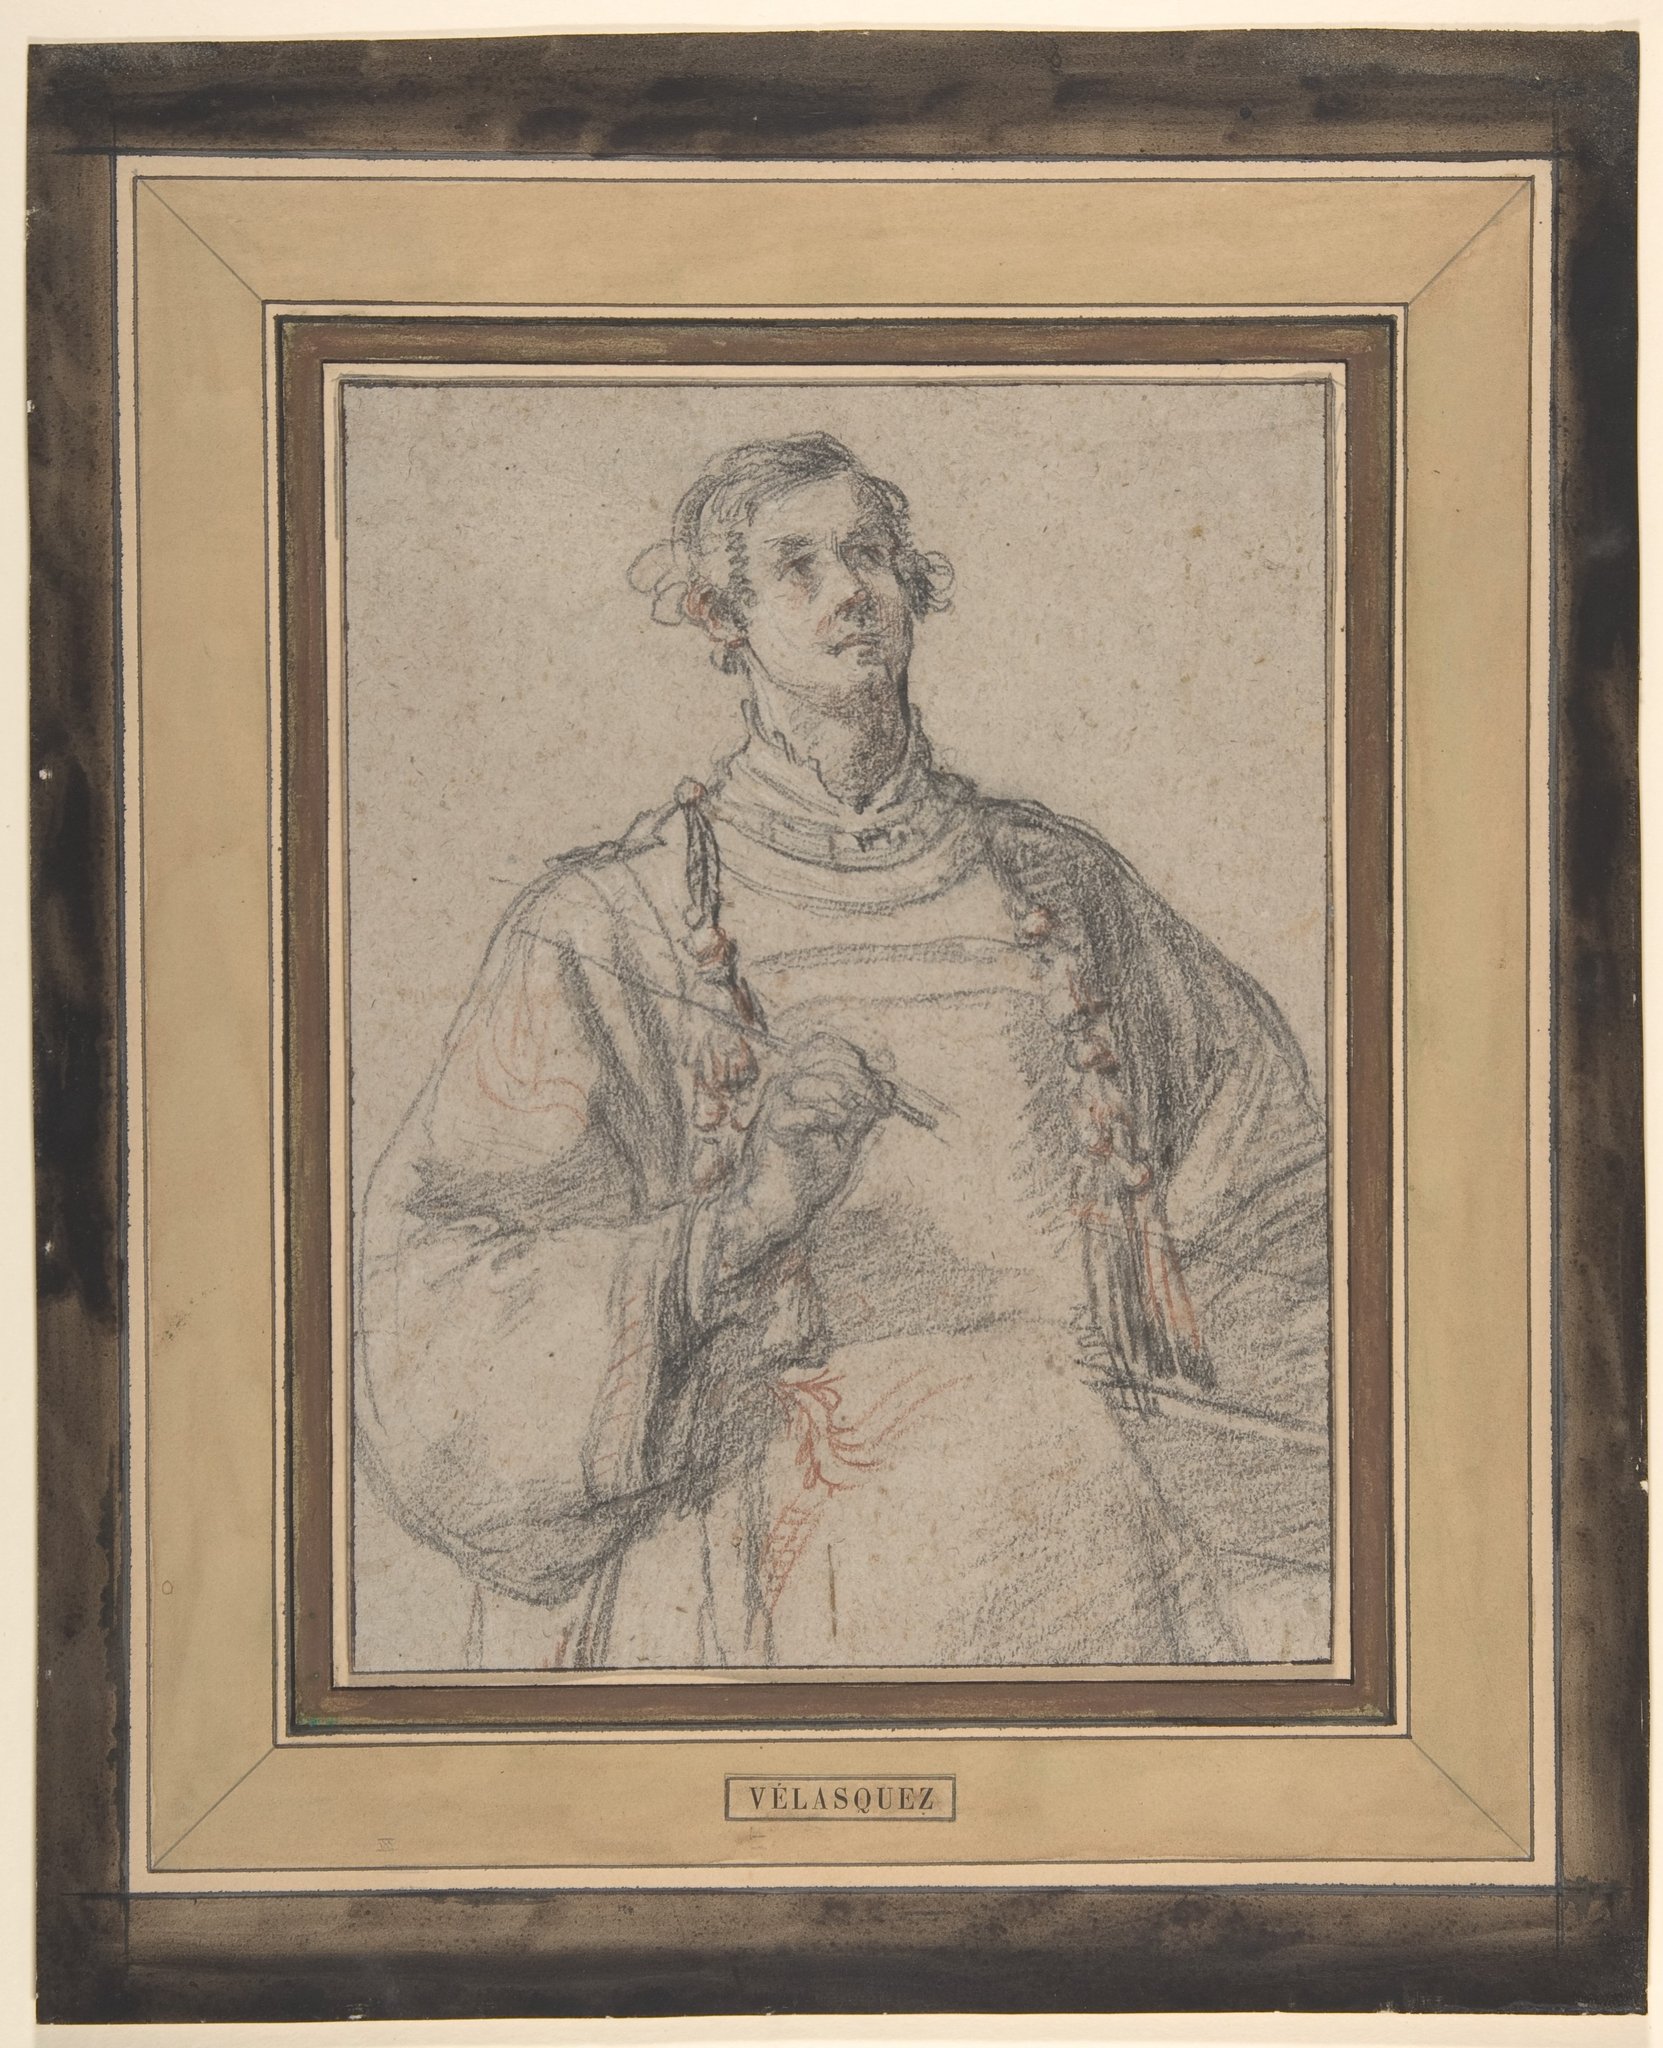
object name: drawing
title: Deacon Saint (Stephen or Lawrence)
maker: jacopo confortini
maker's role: artist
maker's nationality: italian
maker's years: 1602-1672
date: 1640-1650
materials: chalk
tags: men,saints